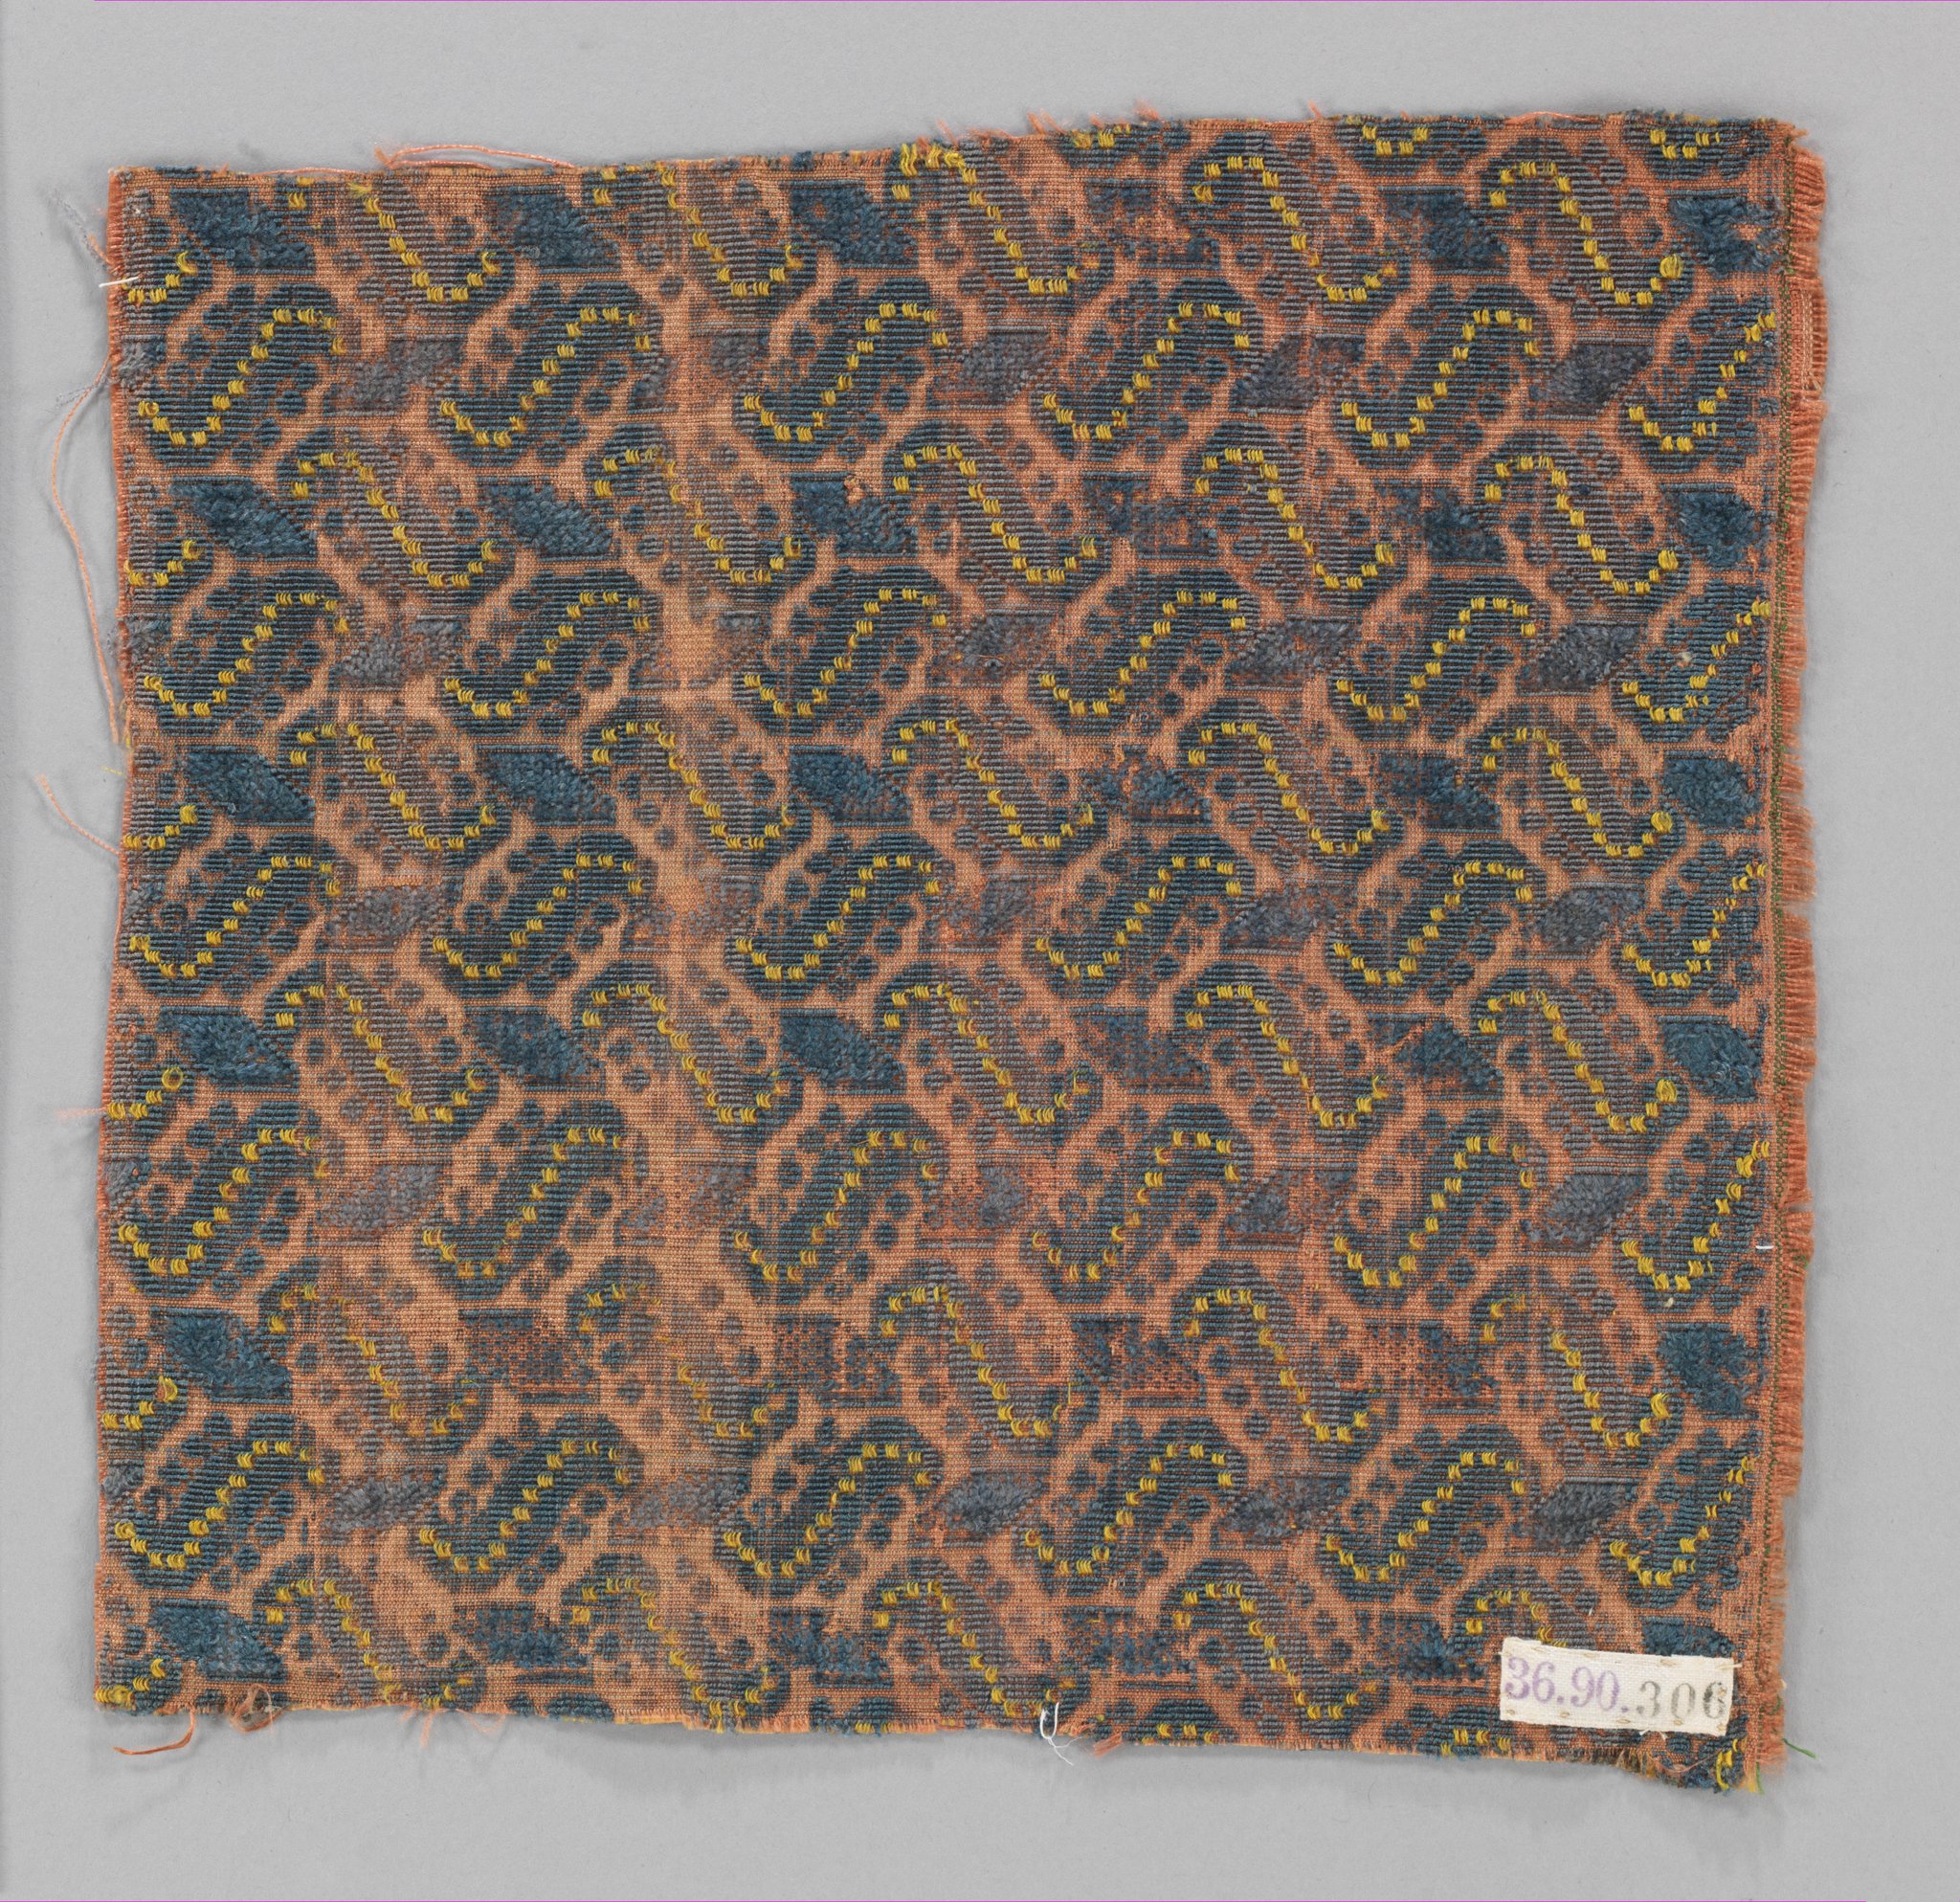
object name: piece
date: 1501-1700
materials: silk